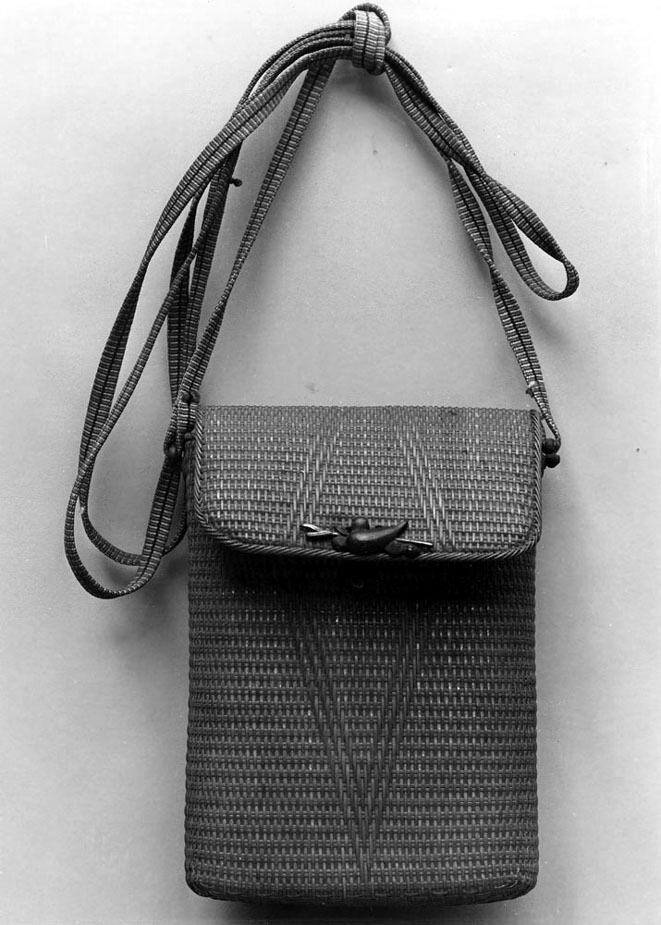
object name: inrō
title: Basket Inrō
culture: japanese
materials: bamboo